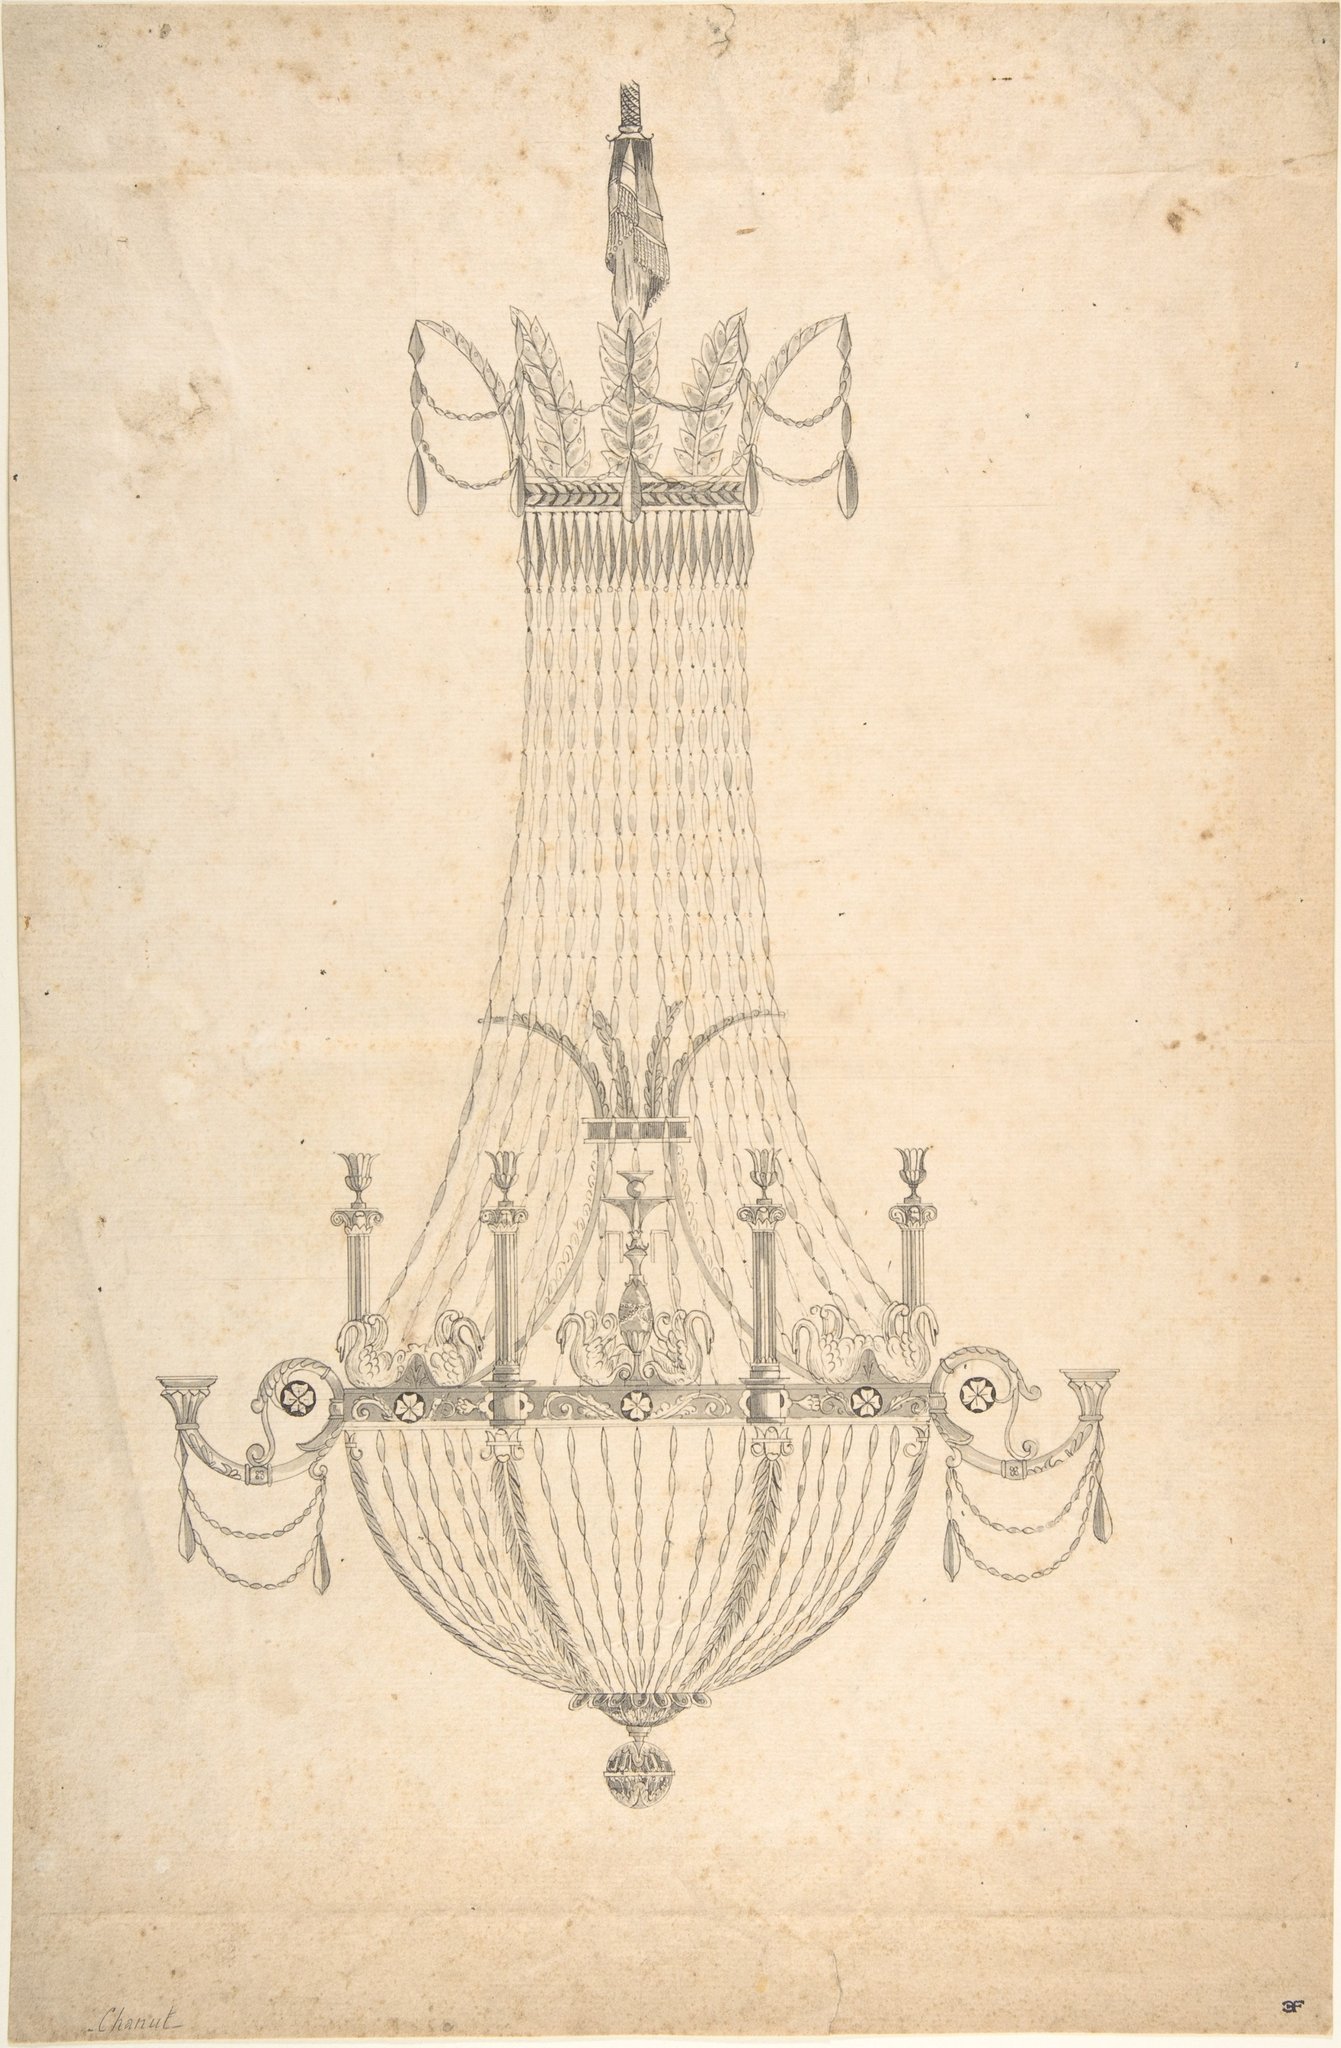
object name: drawing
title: Design for a Chandelier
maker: anonymous, french, 19th century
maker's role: artist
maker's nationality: french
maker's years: 1800-1900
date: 1801-1900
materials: graphite, ink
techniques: brush, pen, wash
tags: chandelier